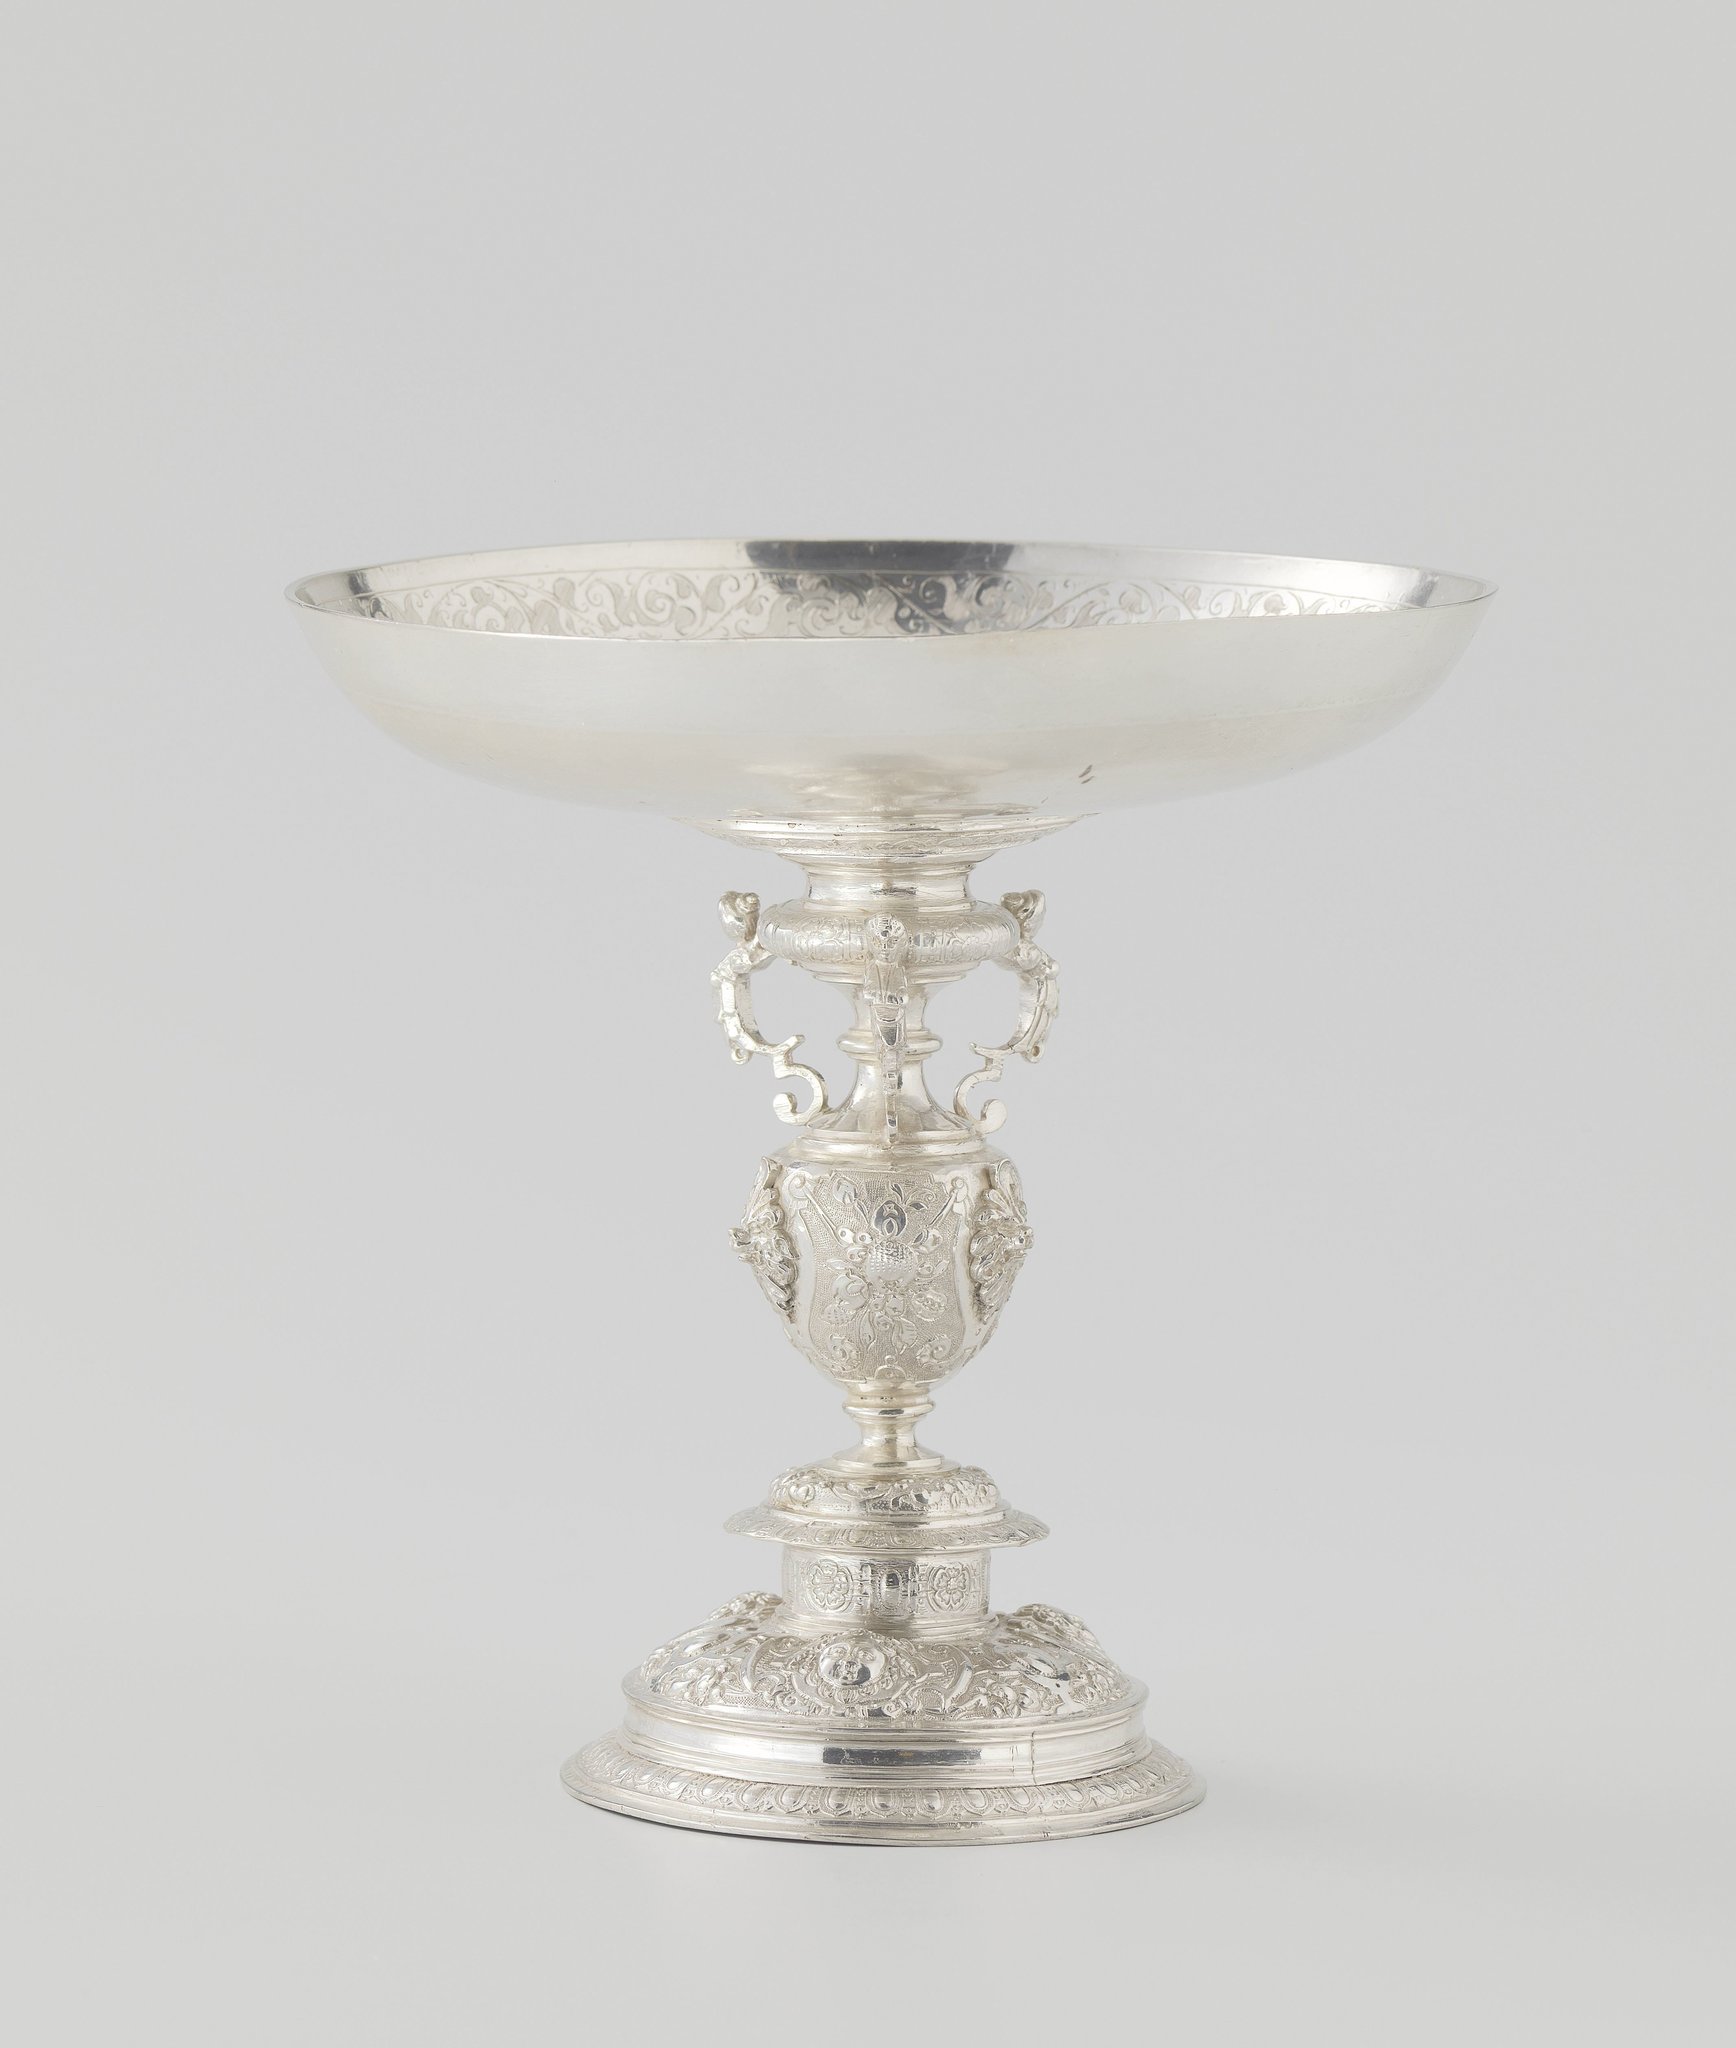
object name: tazza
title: Tazza, with the Imprisonment of Willem Courten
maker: Anonymous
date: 1568-1597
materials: silver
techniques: engraving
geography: london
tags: prison, jail, historical persons, ornament derived from plant forms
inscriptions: inscription: ‘Den 2 Marcy in meenen 1567 dacht duc dalve Guillaume Courten te beroven Sijn leven Maar godt heeft den 29 Marty 1567 door sijn huysvroue Marghuerite victorie ghegheven’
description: A man looks out from behind bars. It is Willem Courten from the Flemish town of Menen. As a follower of Calvin he is taken prisoner on 2 March 1567. However, with his wife’s help he escapes and flees to London. He considers this a victory over the Duke of Alva, so the inscription tells us. He gives this tazza, a memorial in silver, to his children.